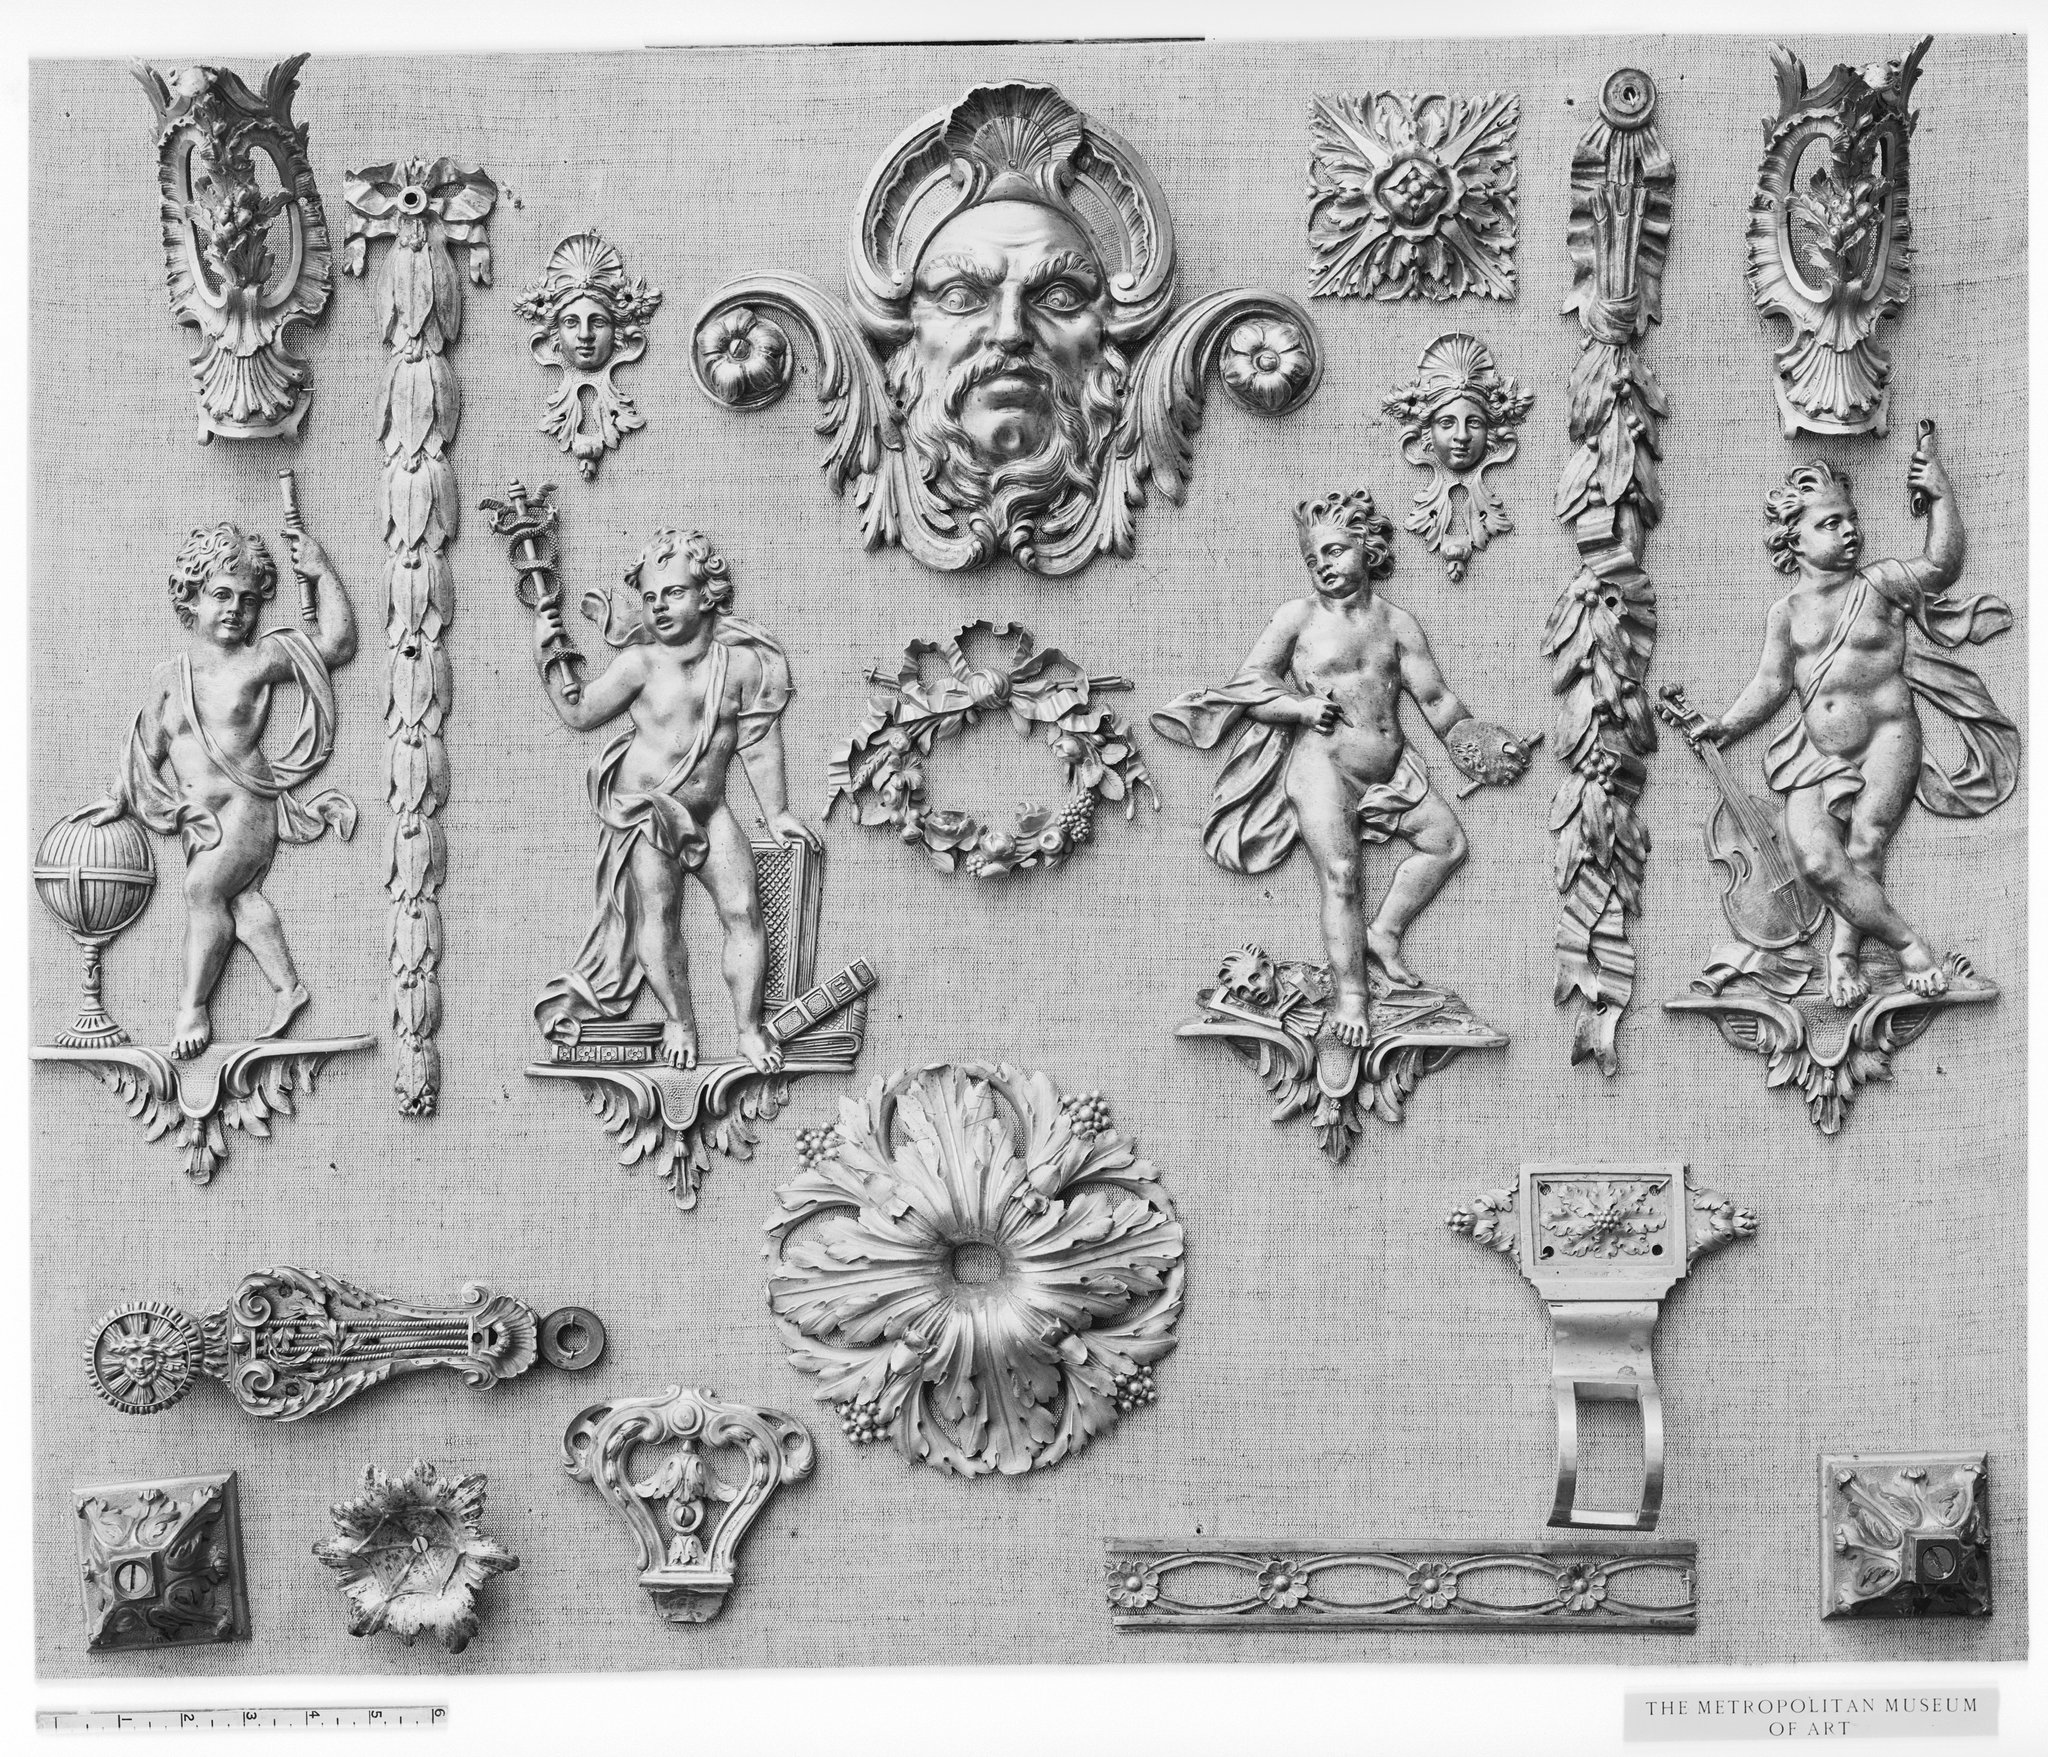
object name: mask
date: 1601-1800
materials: gilt bronze